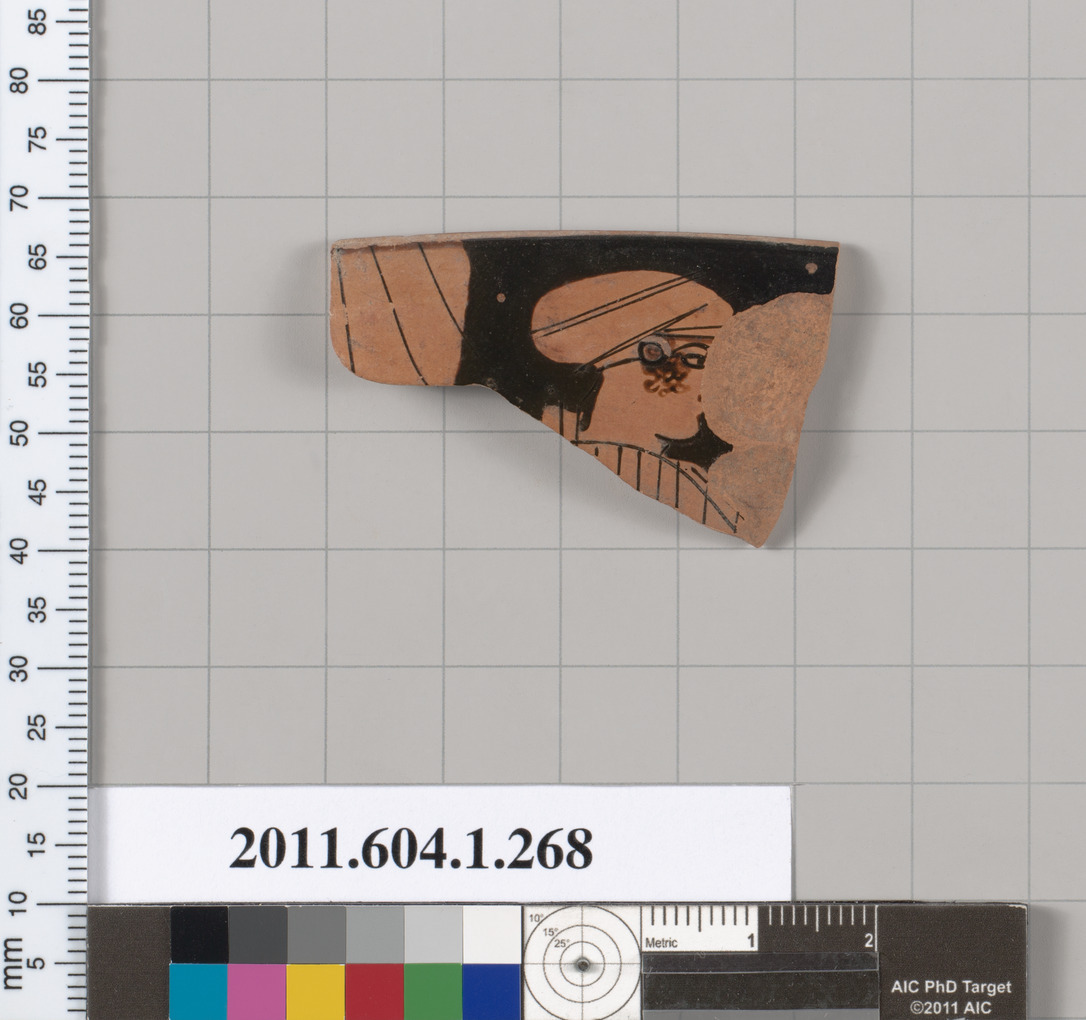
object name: kylix fragment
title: Terracotta rim fragment of a kylix (drinking cup)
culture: greek, attic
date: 475-451 BCE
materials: terracotta